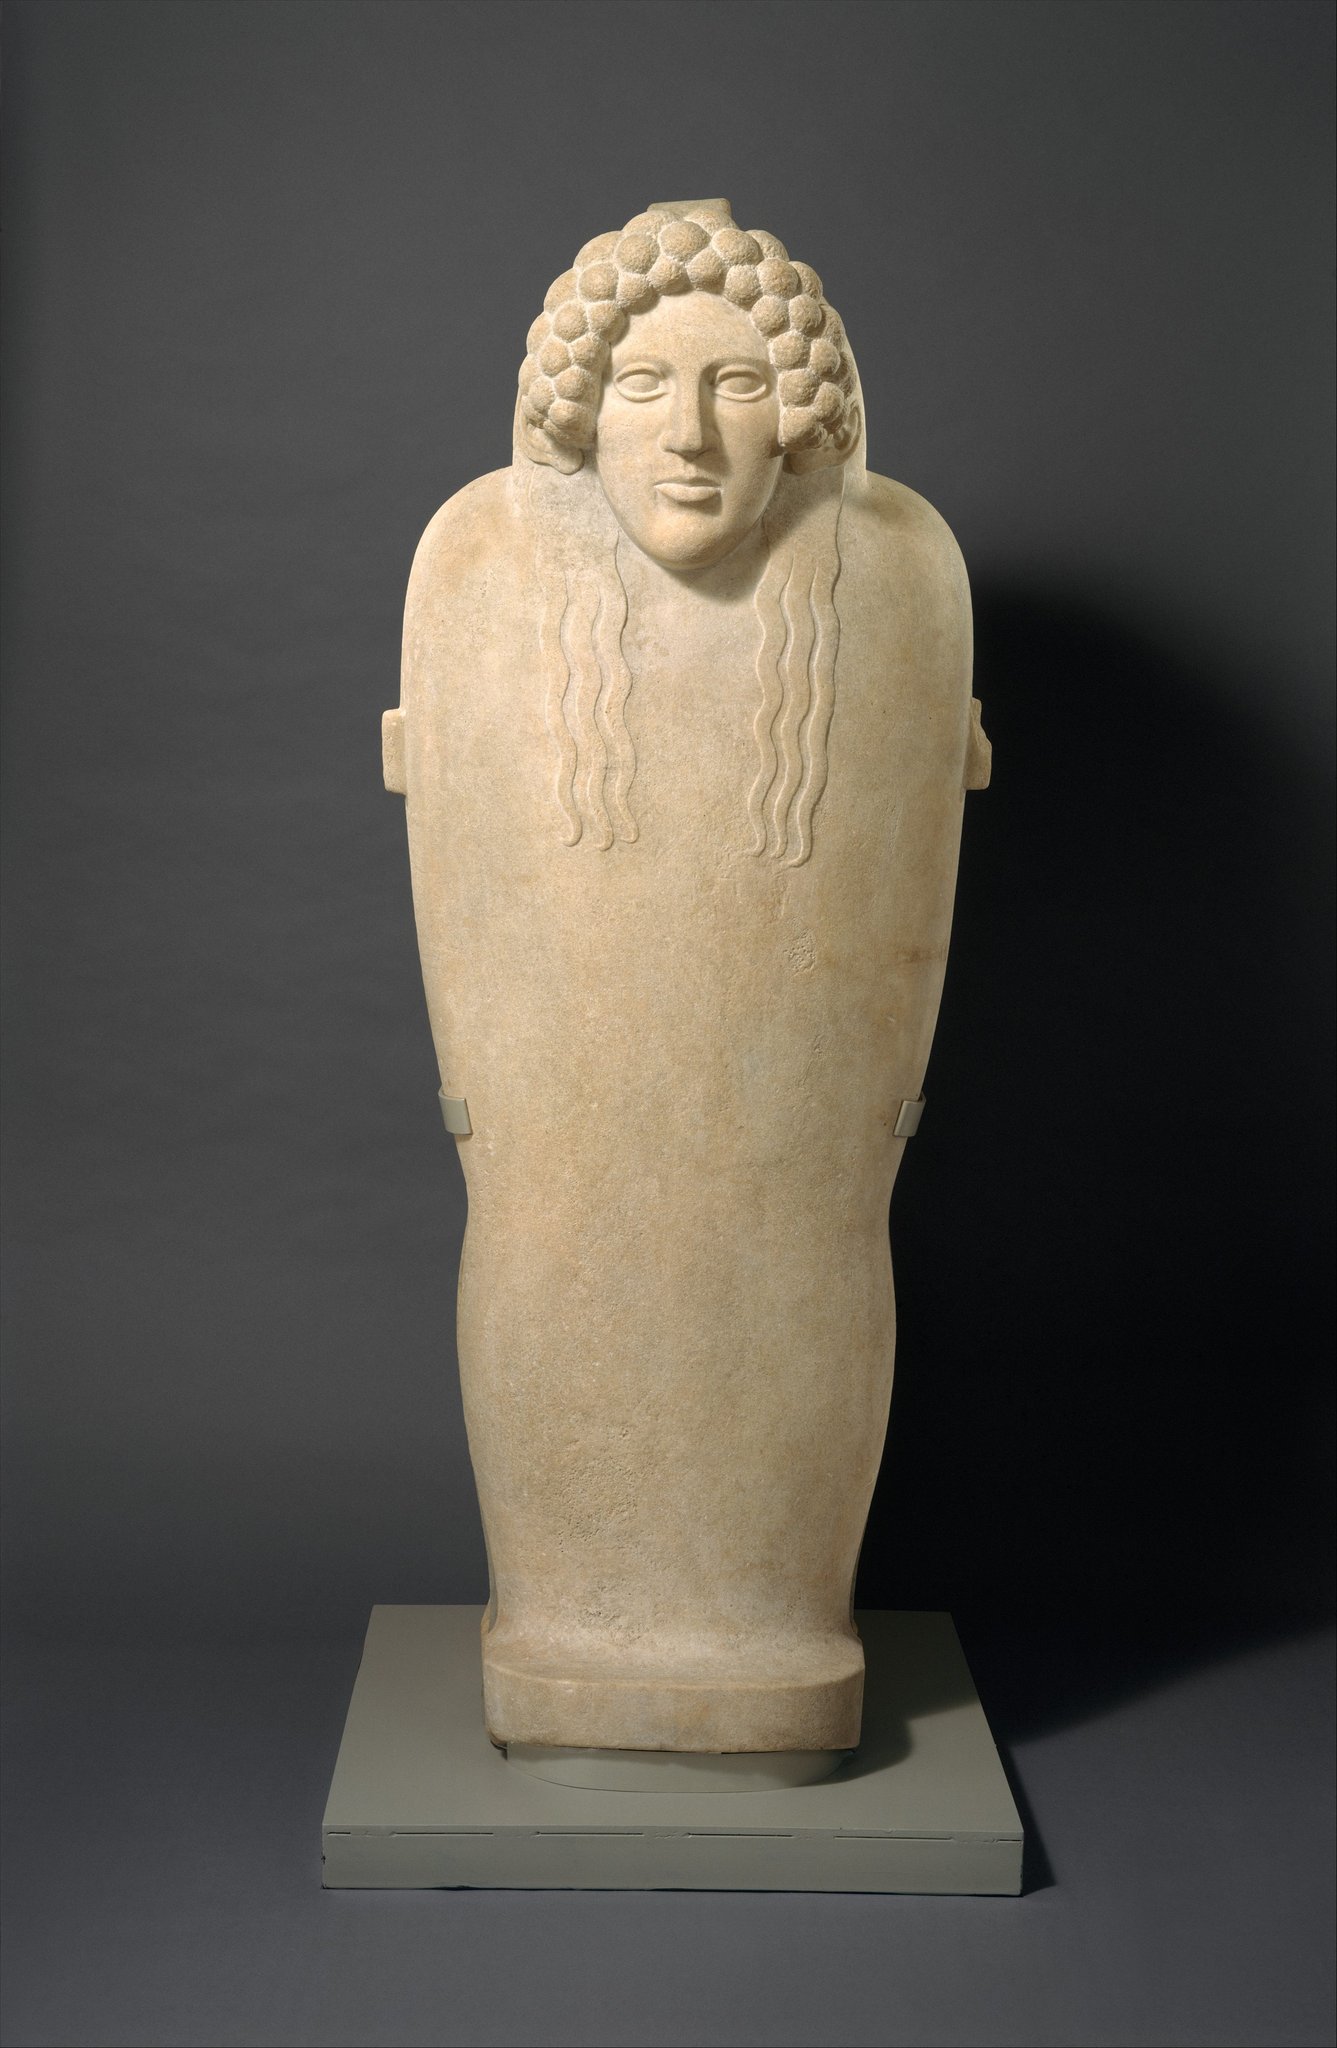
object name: sarcophagus, anthropoid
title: Marble anthropoid sarcophagus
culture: graeco-phoenician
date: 425-401 BCE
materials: marble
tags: sarcophagus